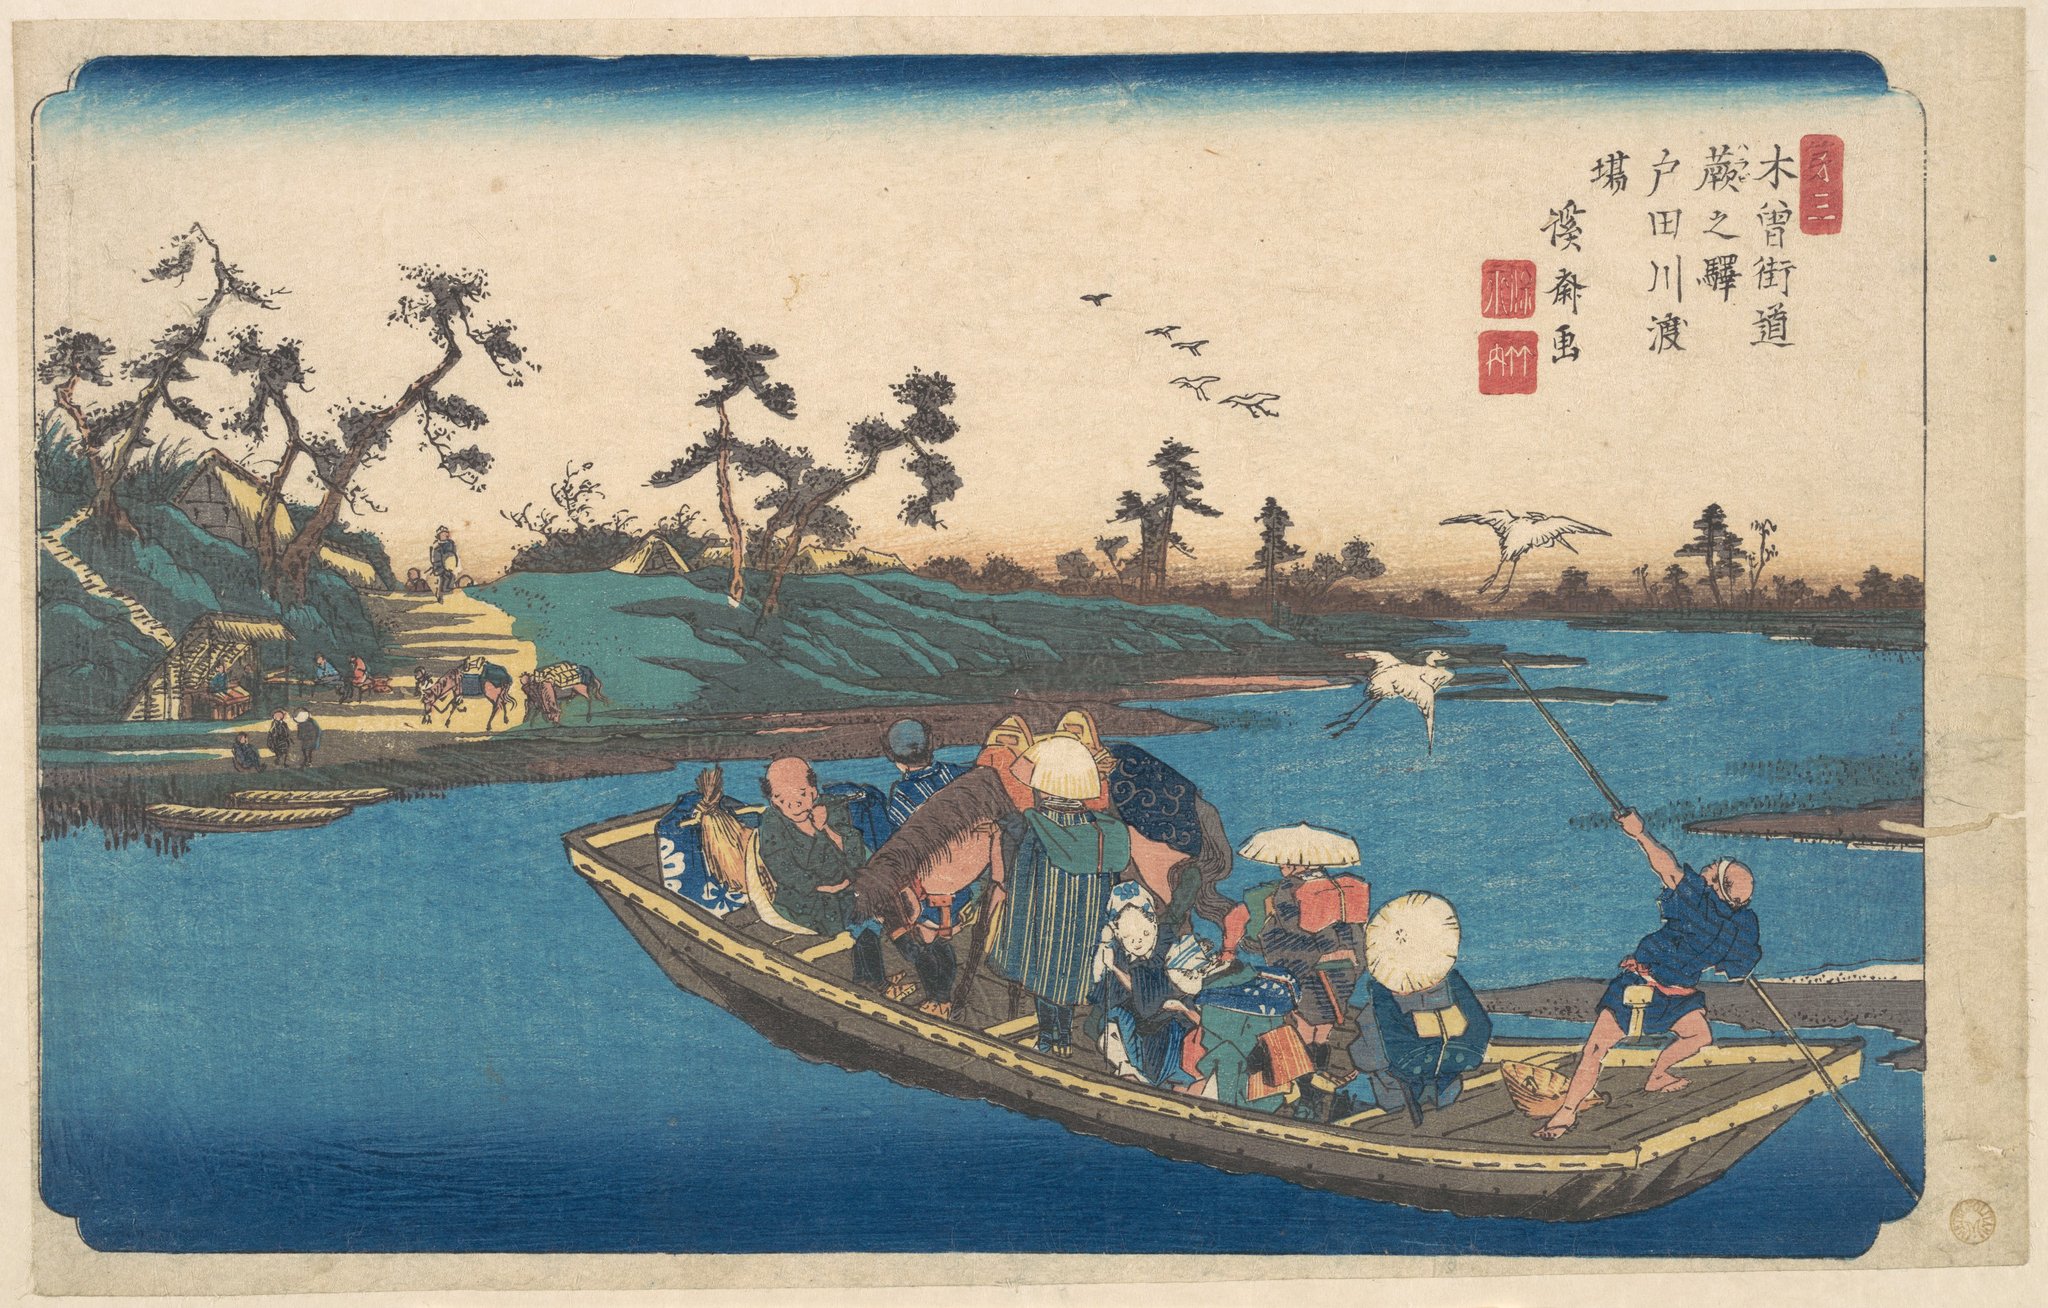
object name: print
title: Warabi no Eki, Todogawa Watashi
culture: japanese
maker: keisai eisen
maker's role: artist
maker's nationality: japanese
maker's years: 1790-1848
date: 1838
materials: ink, paper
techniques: woodblock print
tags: cranes,men,horses,rivers,boats